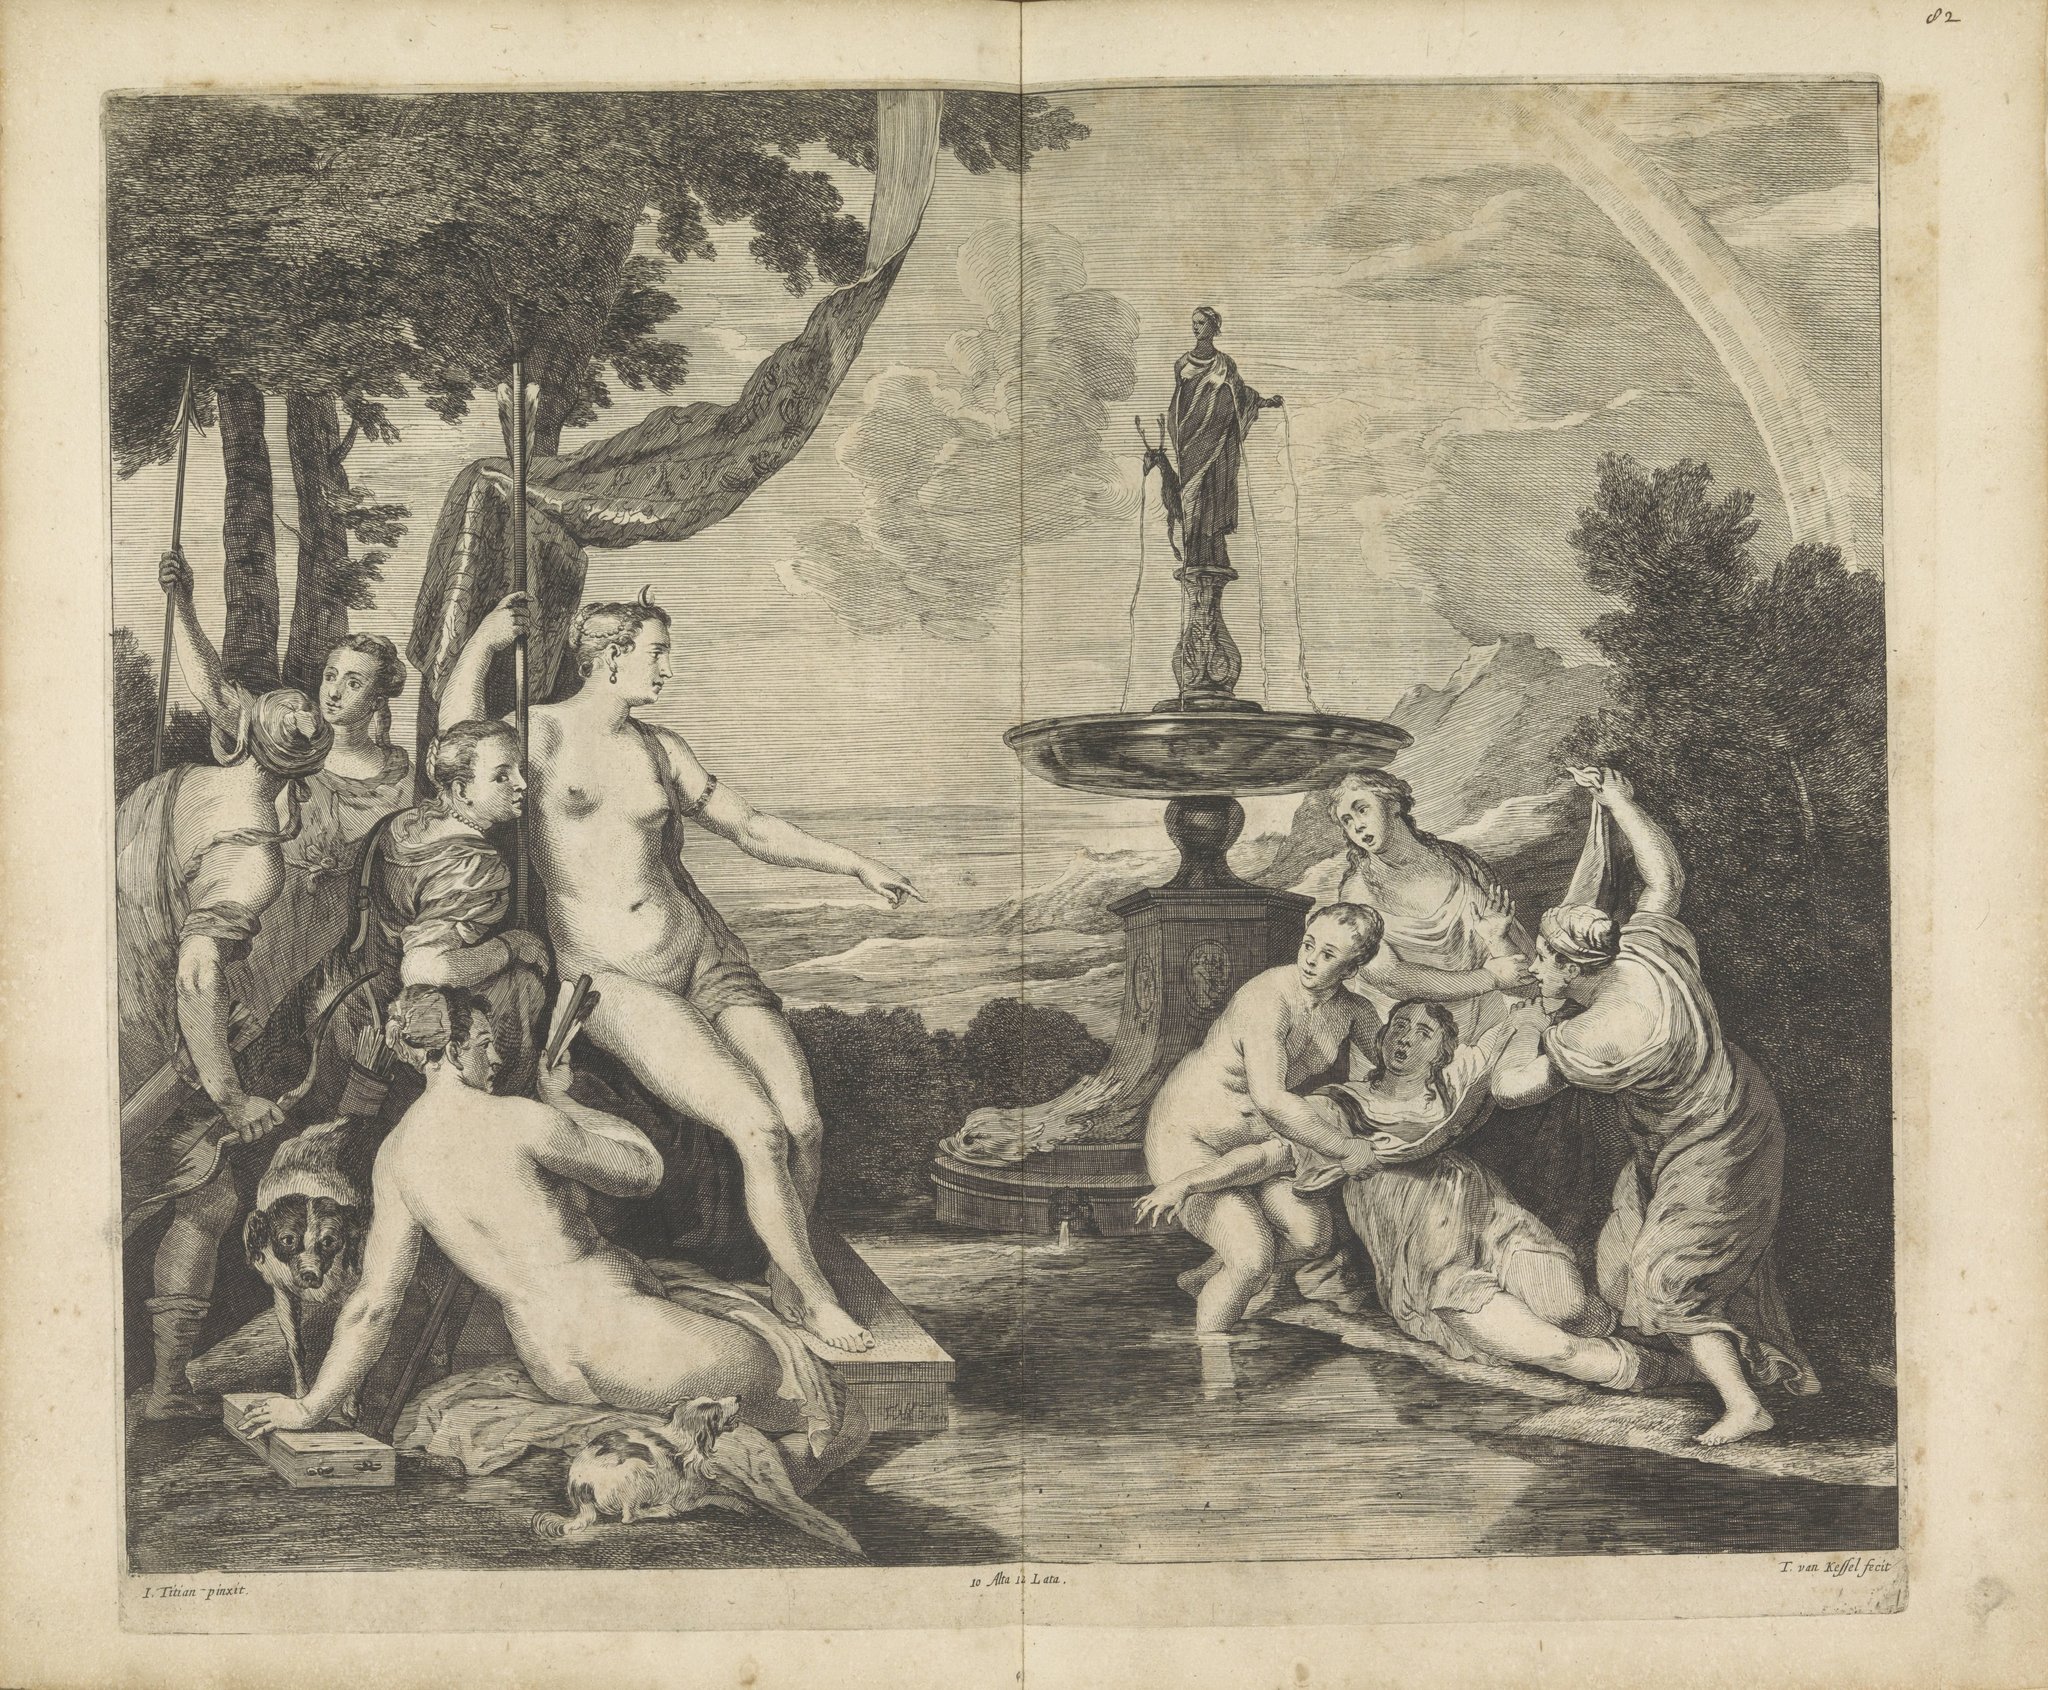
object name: album leaf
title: Diana ontdekt de zwangerschap van Callisto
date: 1660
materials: paper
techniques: engraving, etching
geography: italy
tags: diana with her nymphs discovers the pregnancy of callisto, pregnancy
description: De prent is vervaardigd naar het schilderij van Titiaan dat zich in de collectie van het Kunsthistorisches Museum te Wenen bevindt (inventarisnummer GG_71). De geschilderde kopie van Teniers bevindt zich in de Gemäldegalerie der Akademie der bildenden Künste te Wenen. David Teniers heeft waarschijnlijk van alle schilderijen uit de collectie van Leopold Willem van Oostenrijk een olieverfstudie op doek of paneel vervaardigd (zgn. pasticcio), die als voorbeeld voor de prentmakers diende. Het is niet altijd duidelijk of de pasticci door hem zijn gemaakt of door zijn atelier. Niet alle pasticci zijn overgeleverd.